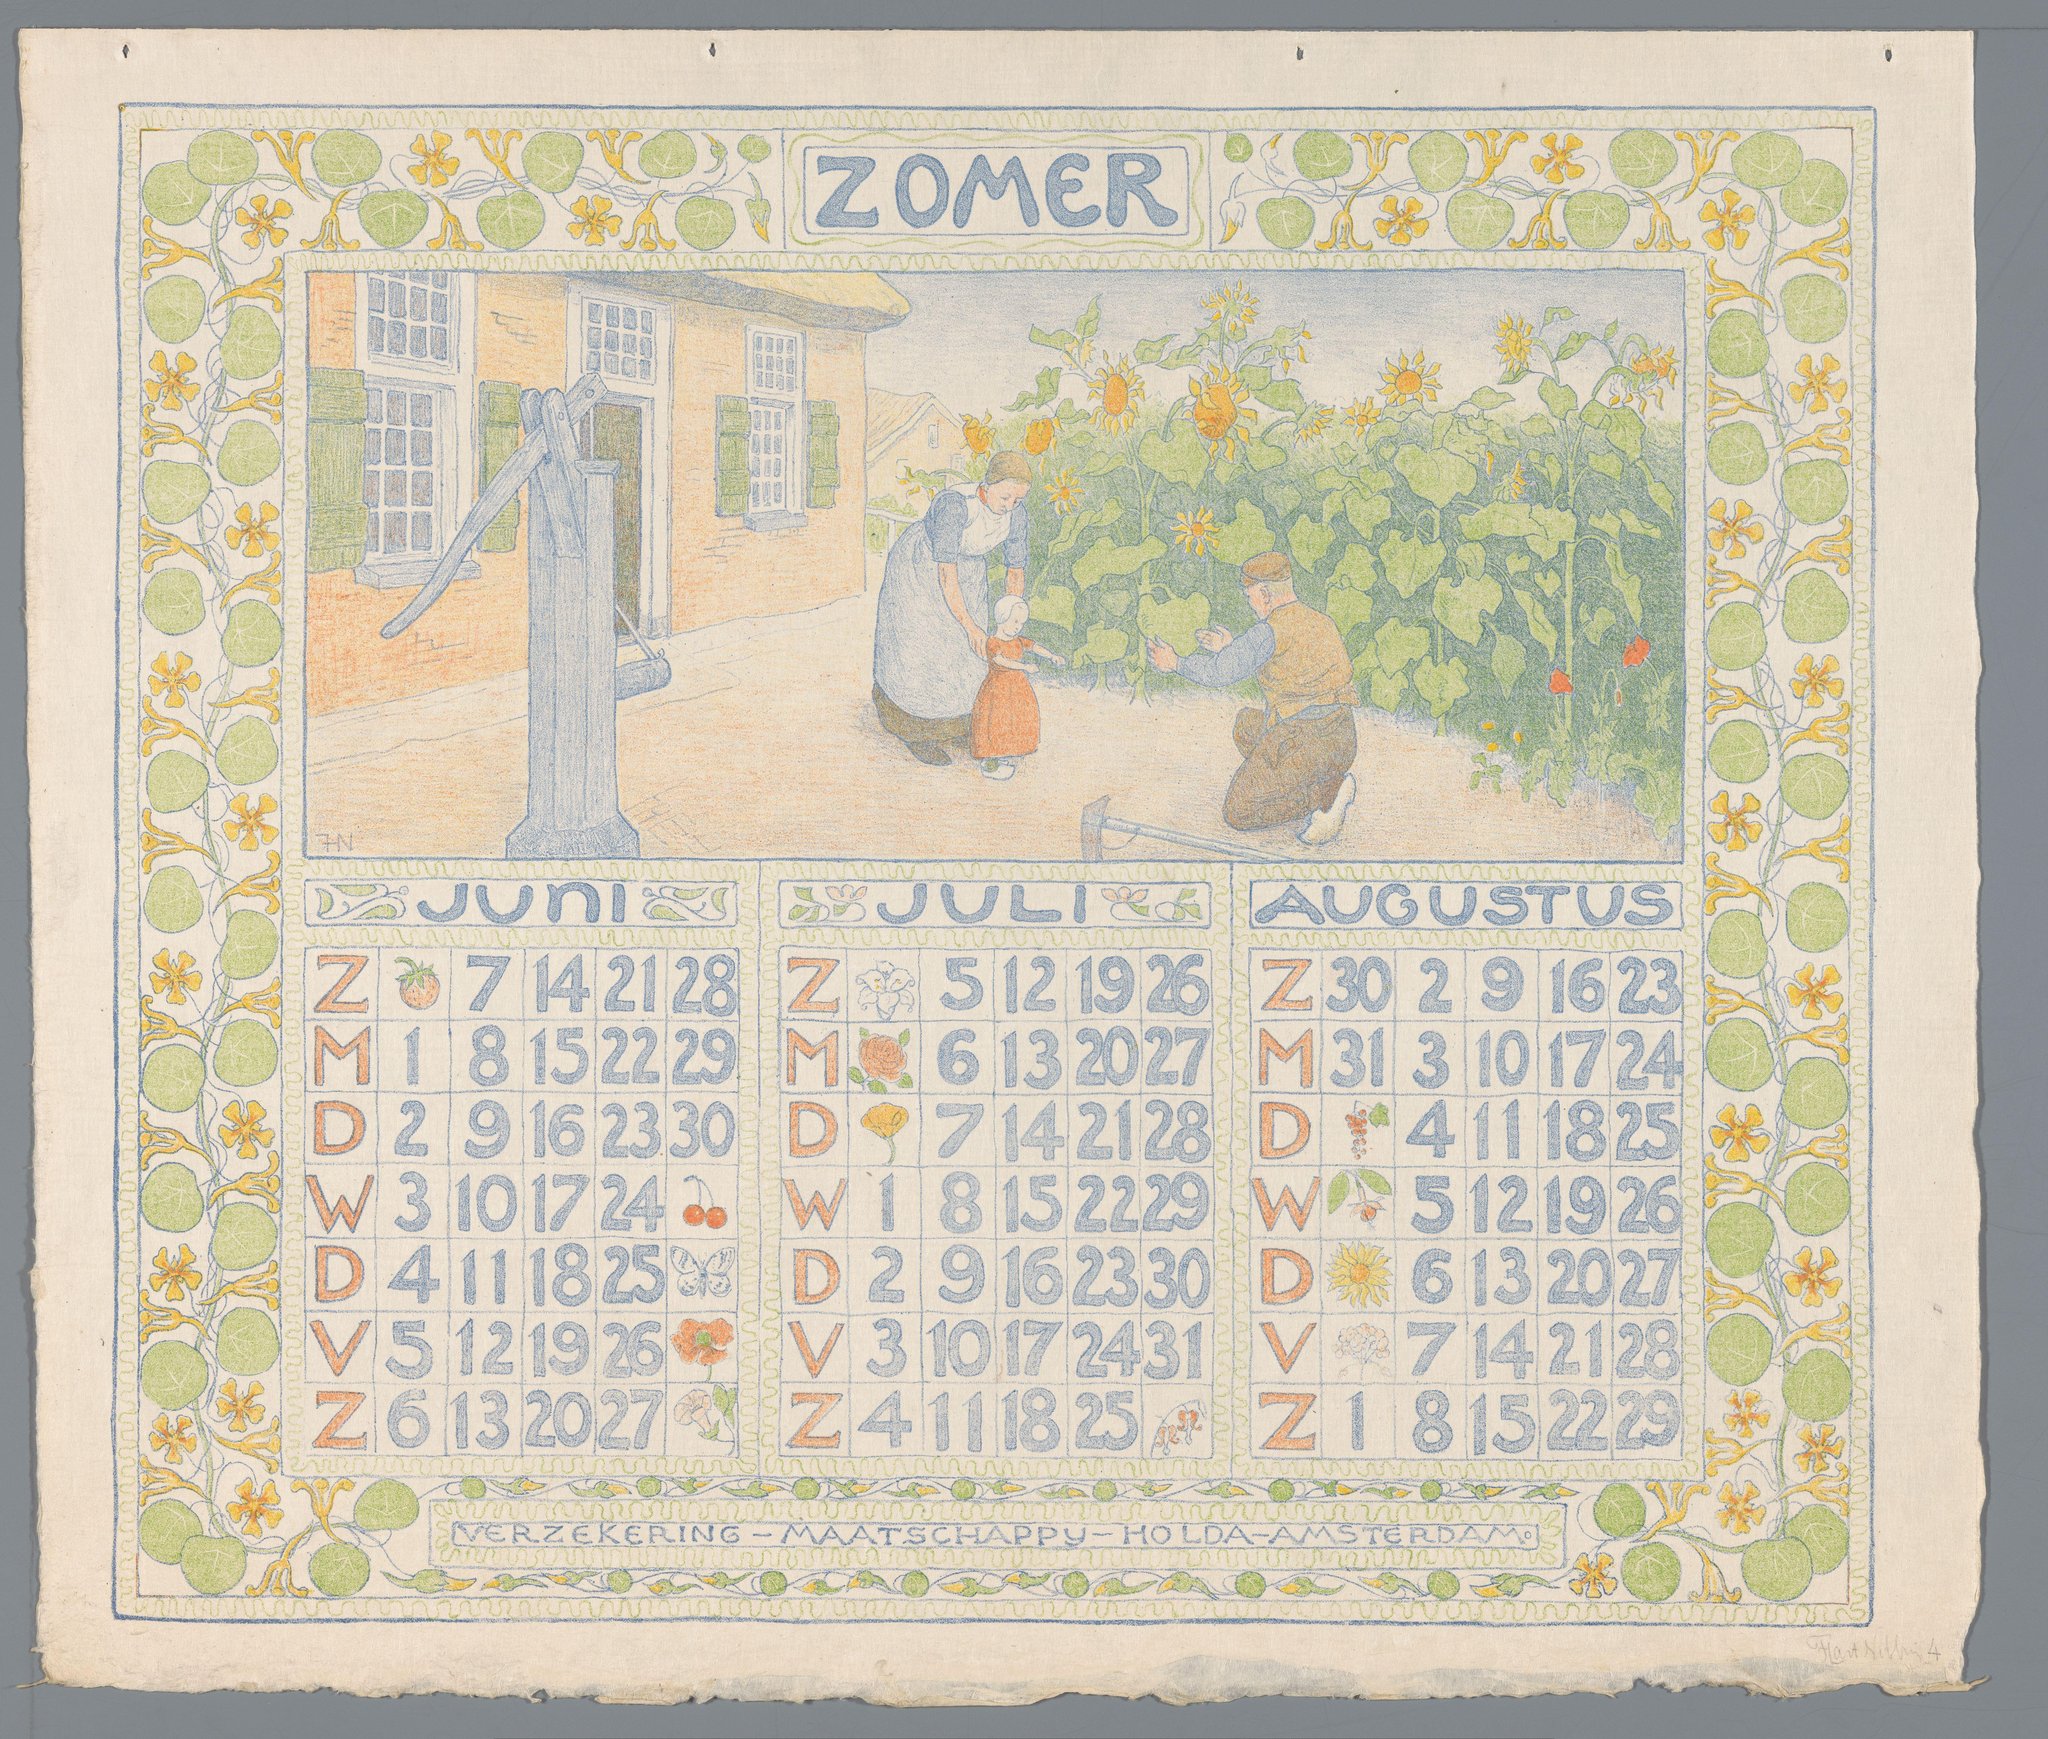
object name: print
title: Kalenderblad voor zomer 1904 van de Verzekering-Maatschappij Holda in Amsterdam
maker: ferdinand hart nibbrig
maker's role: draughtsman, painter, print maker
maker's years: 1866-1915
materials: paper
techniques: lithograph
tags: flowers: sunflower, summer ~ human activities (the four seasons of the year), pump, farm (building)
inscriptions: collector's mark: Lugt 2228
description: Een rechthoekig kader opgevuld met de dagen van de maanden juni, juli en augustus en daarboven een man en een vrouw die een meisje leren lopen. Links een waterpomp bij een boerderij. Rechts zonnebloemen.